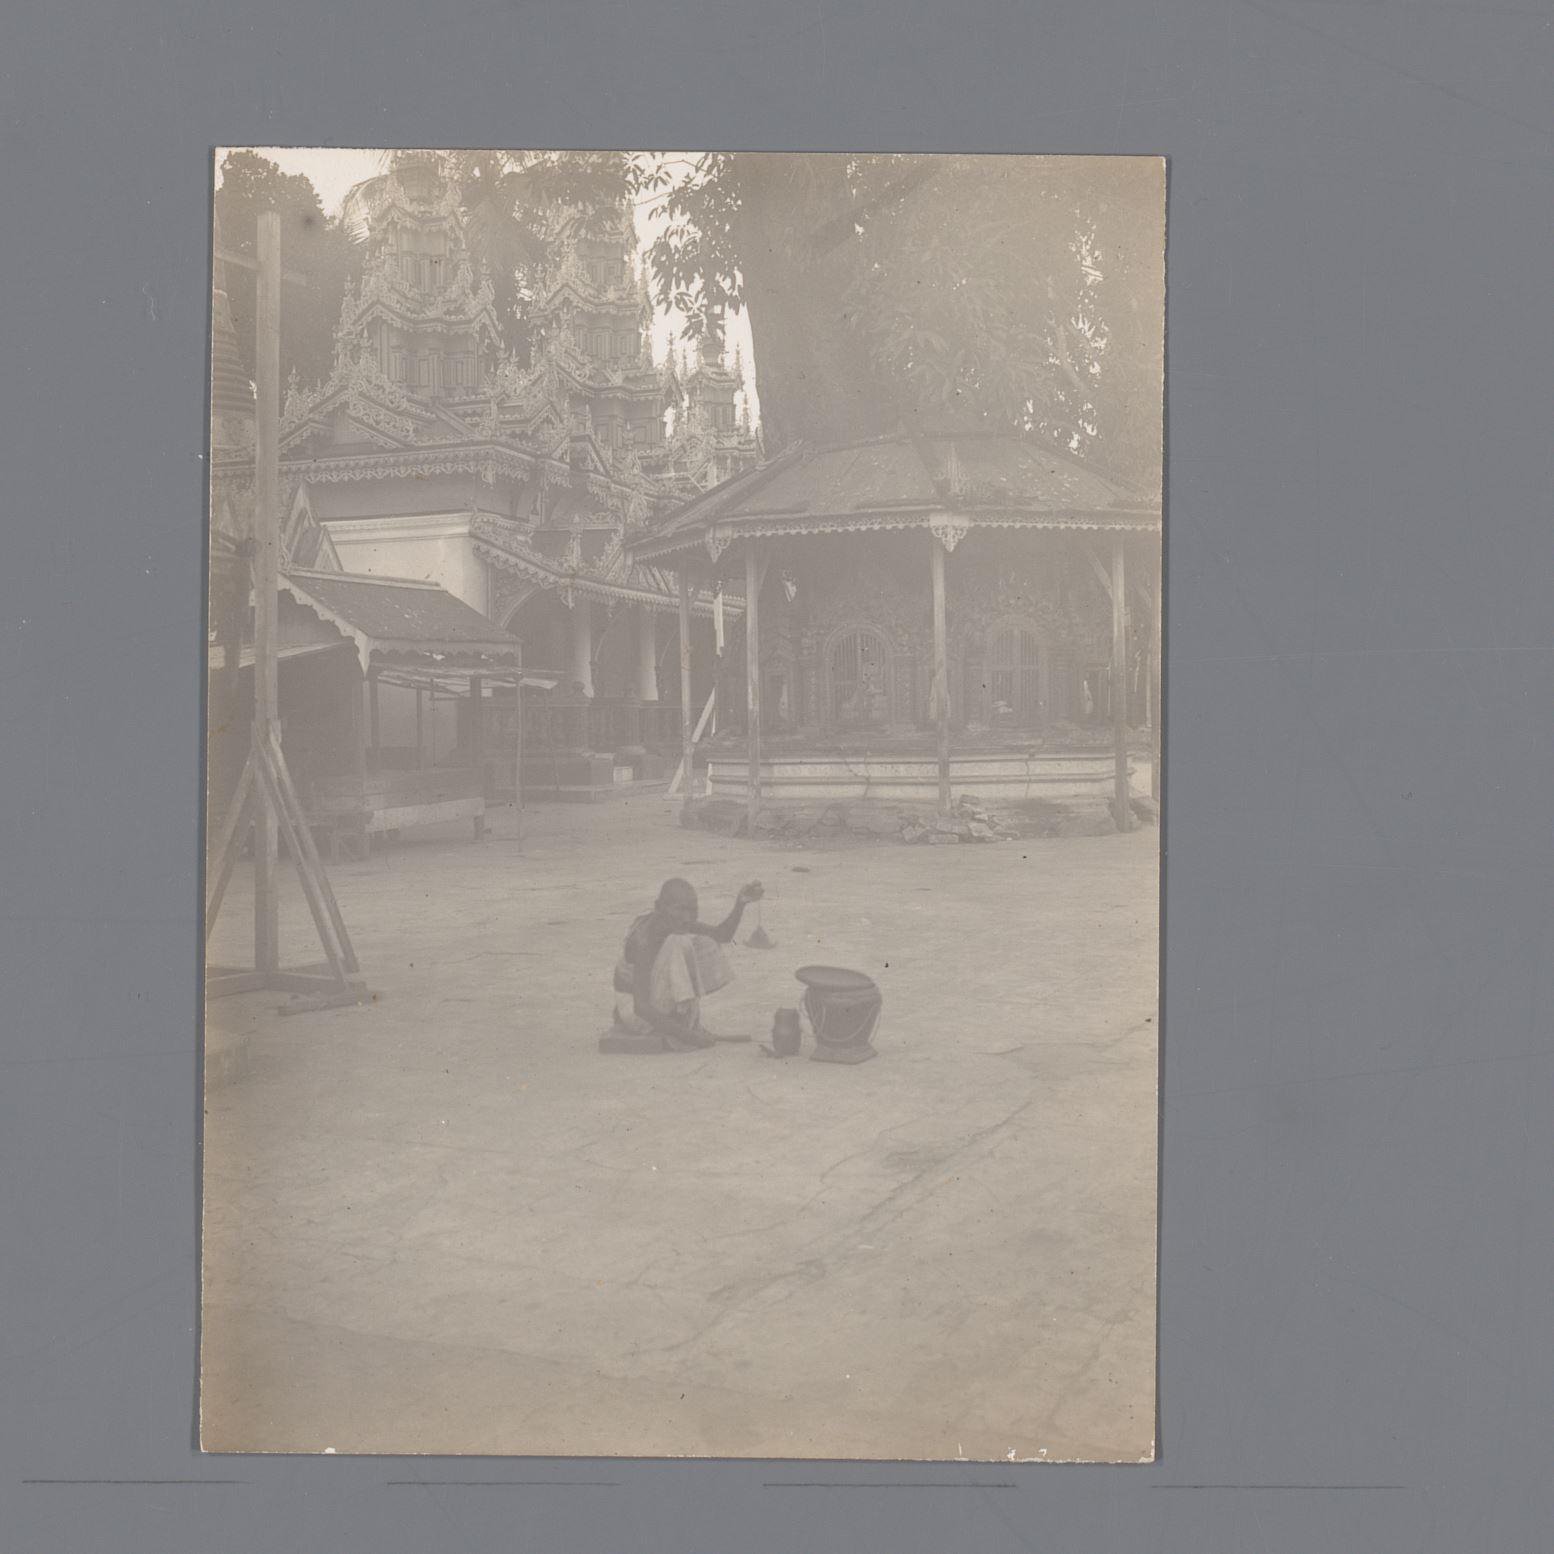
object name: photograph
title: A crouching man in the courtyard of a shrine, Myanmar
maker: jan adriani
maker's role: fotograaf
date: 1907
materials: photographic support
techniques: gelatin silver print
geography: southeast asia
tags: places and objects of worship ~ hinduism, buddhism, jainism, squatting, crouching figure